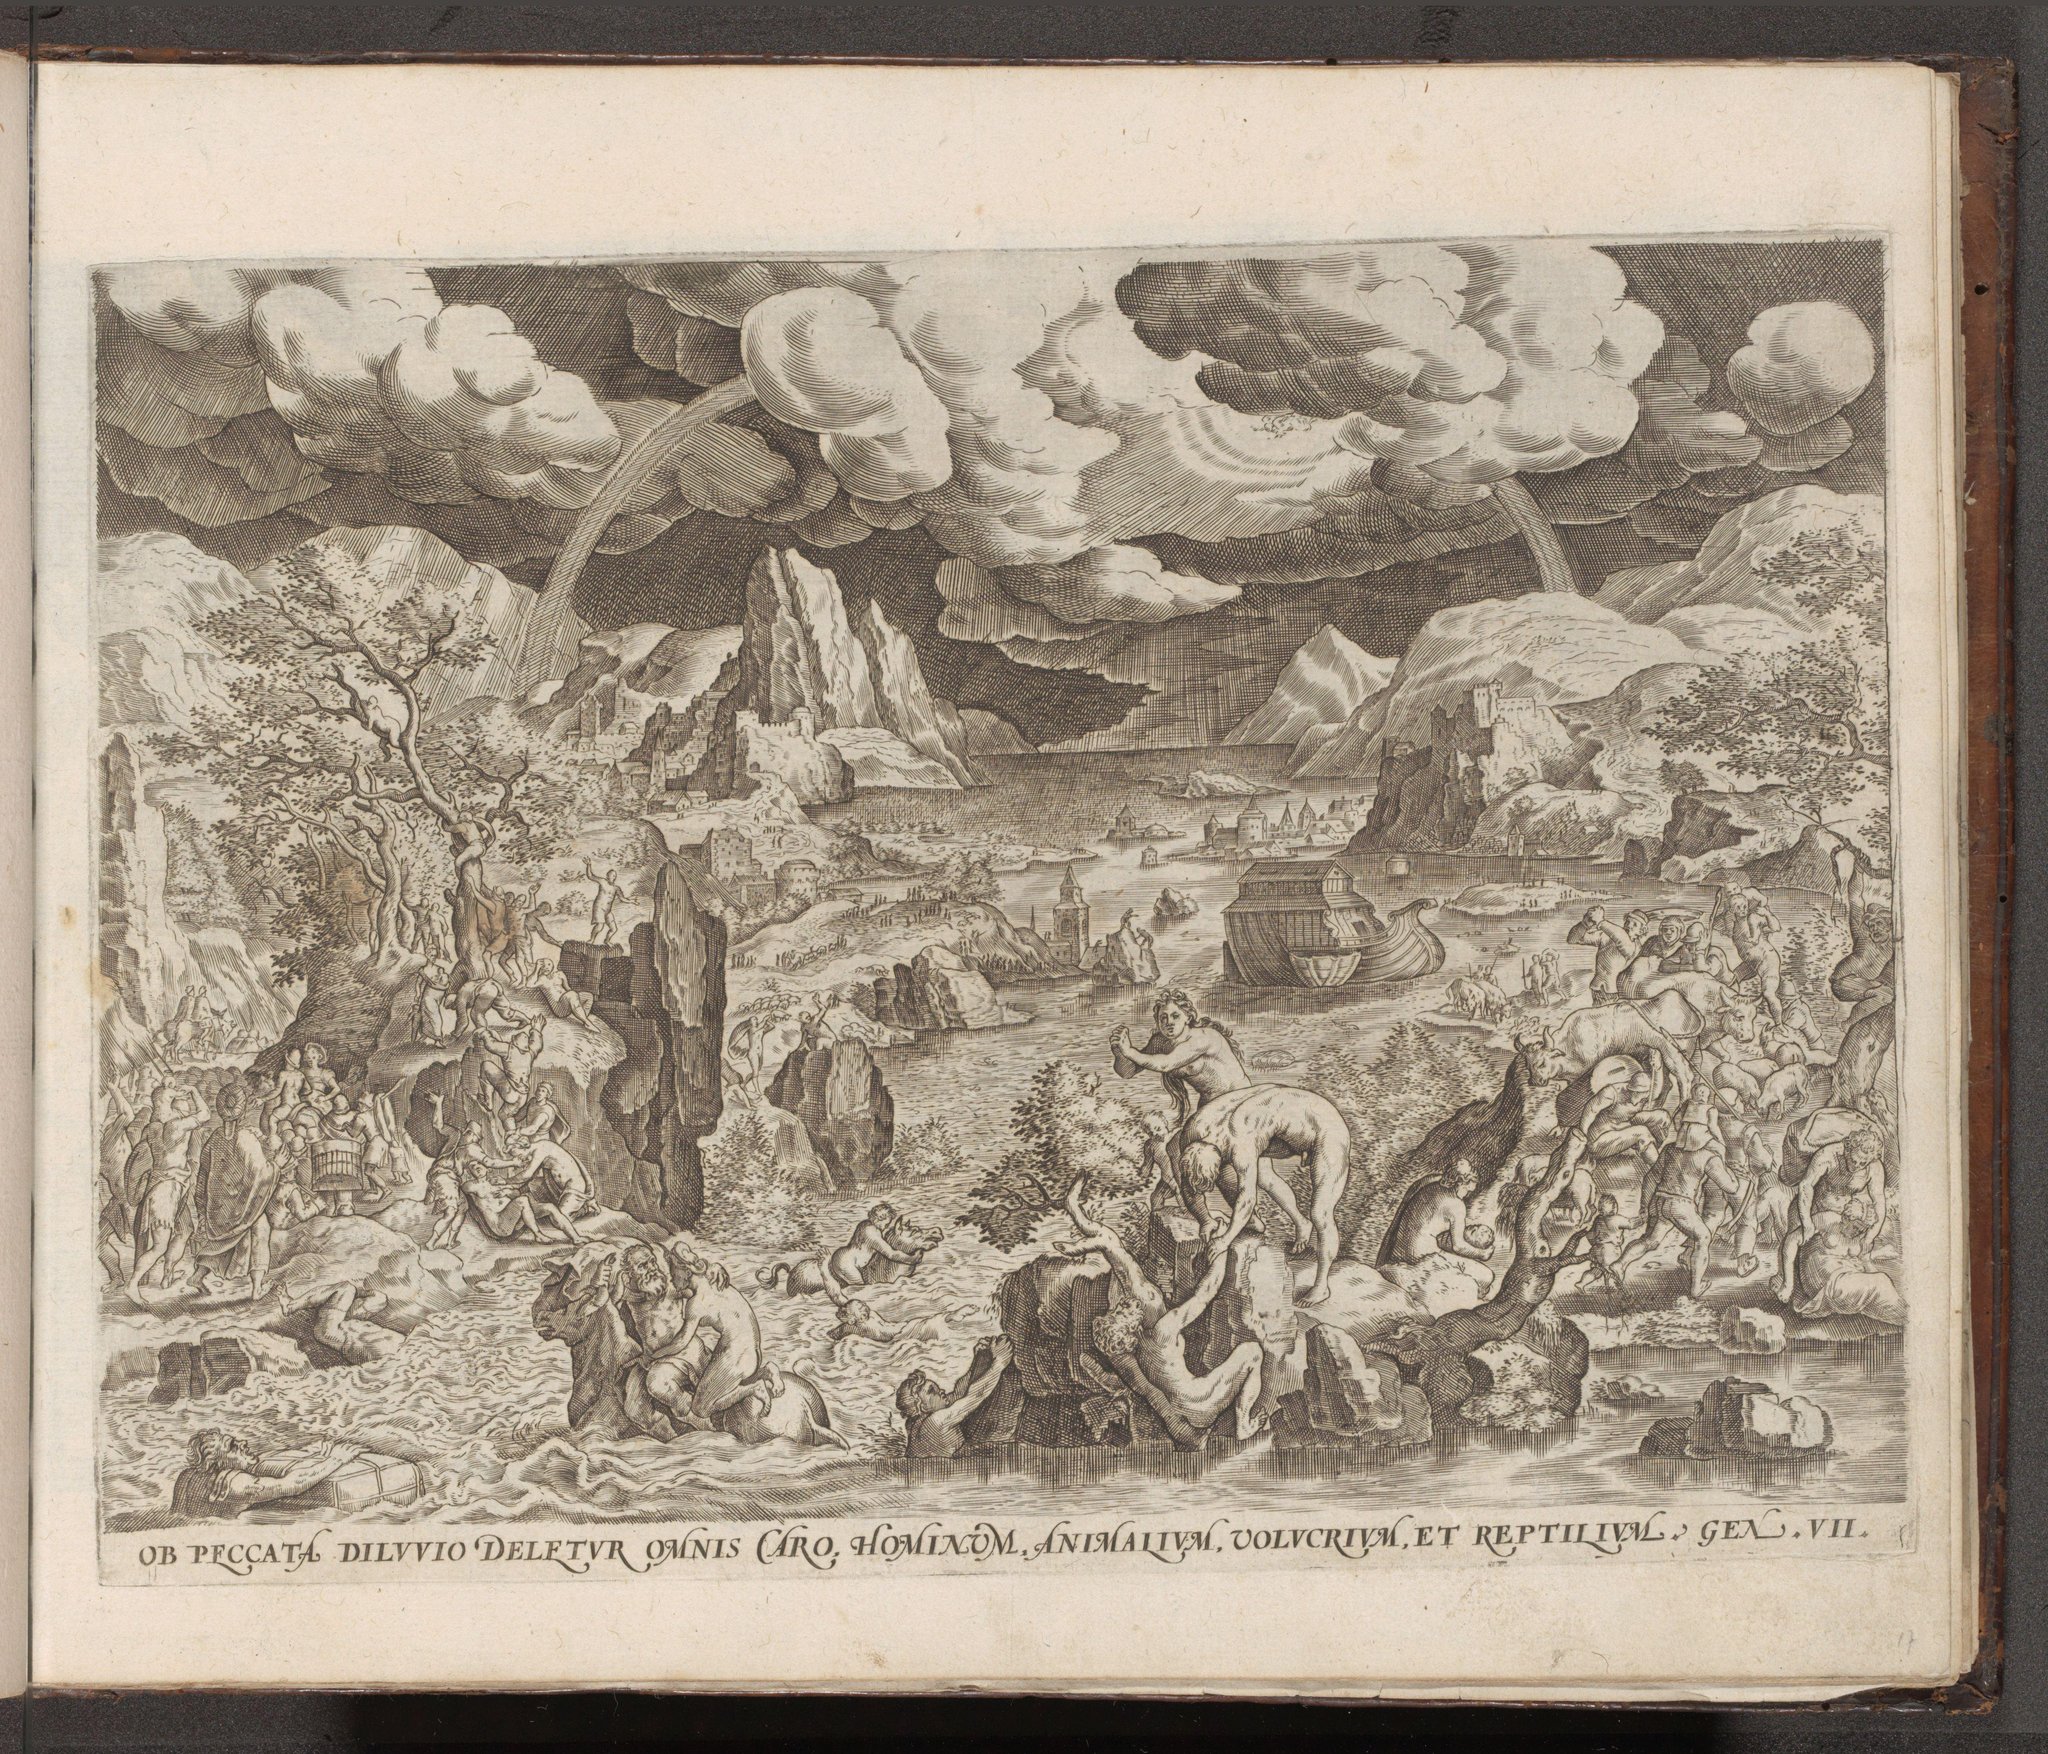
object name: album leaf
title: Zondvloed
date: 1579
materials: paper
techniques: engraving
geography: antwerp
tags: the flood and destruction of mankind ~ story of noah (genesis 7:10 - 8:17), the ark is floating on the waters, while life on earth is destroyed ~ story of noah, death by drowning (non-violent), climbing up a tree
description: De zondvloed overstroomt het land. Mensen en dieren worden verzwolgen door het water. Mensen proberen zich te redden door op hoger gelegen land en in bomen te klimmen. Op de achtergrond drijft de ark van Noach. Onderaan een verwijzing naar de Bijbeltekst in Gen. 7 in het Latijn. Prent maakt deel uit van een album.